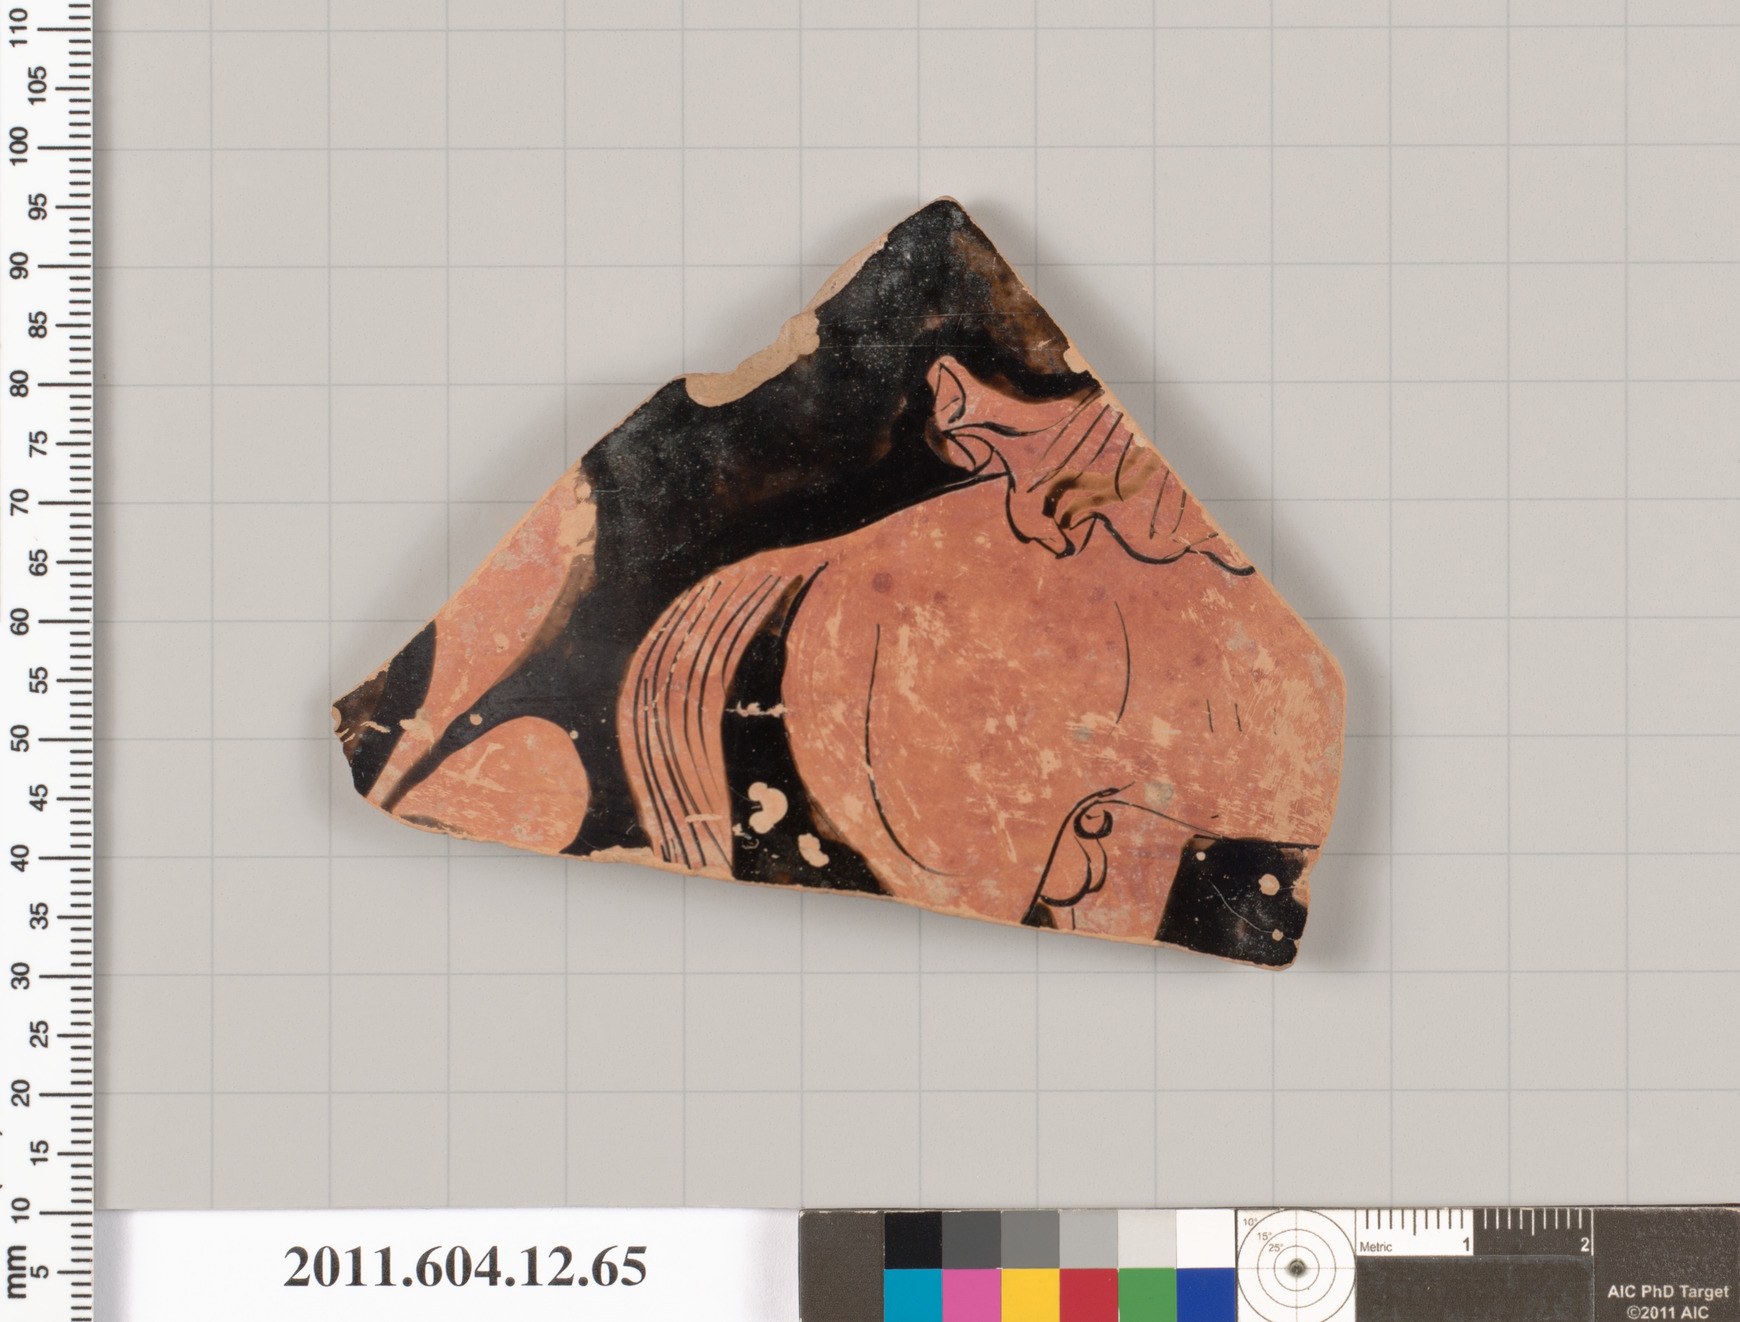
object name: undetermined open shape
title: Terracotta fragment of an open shape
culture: greek or south italian or campanian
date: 367-335 BCE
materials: terracotta